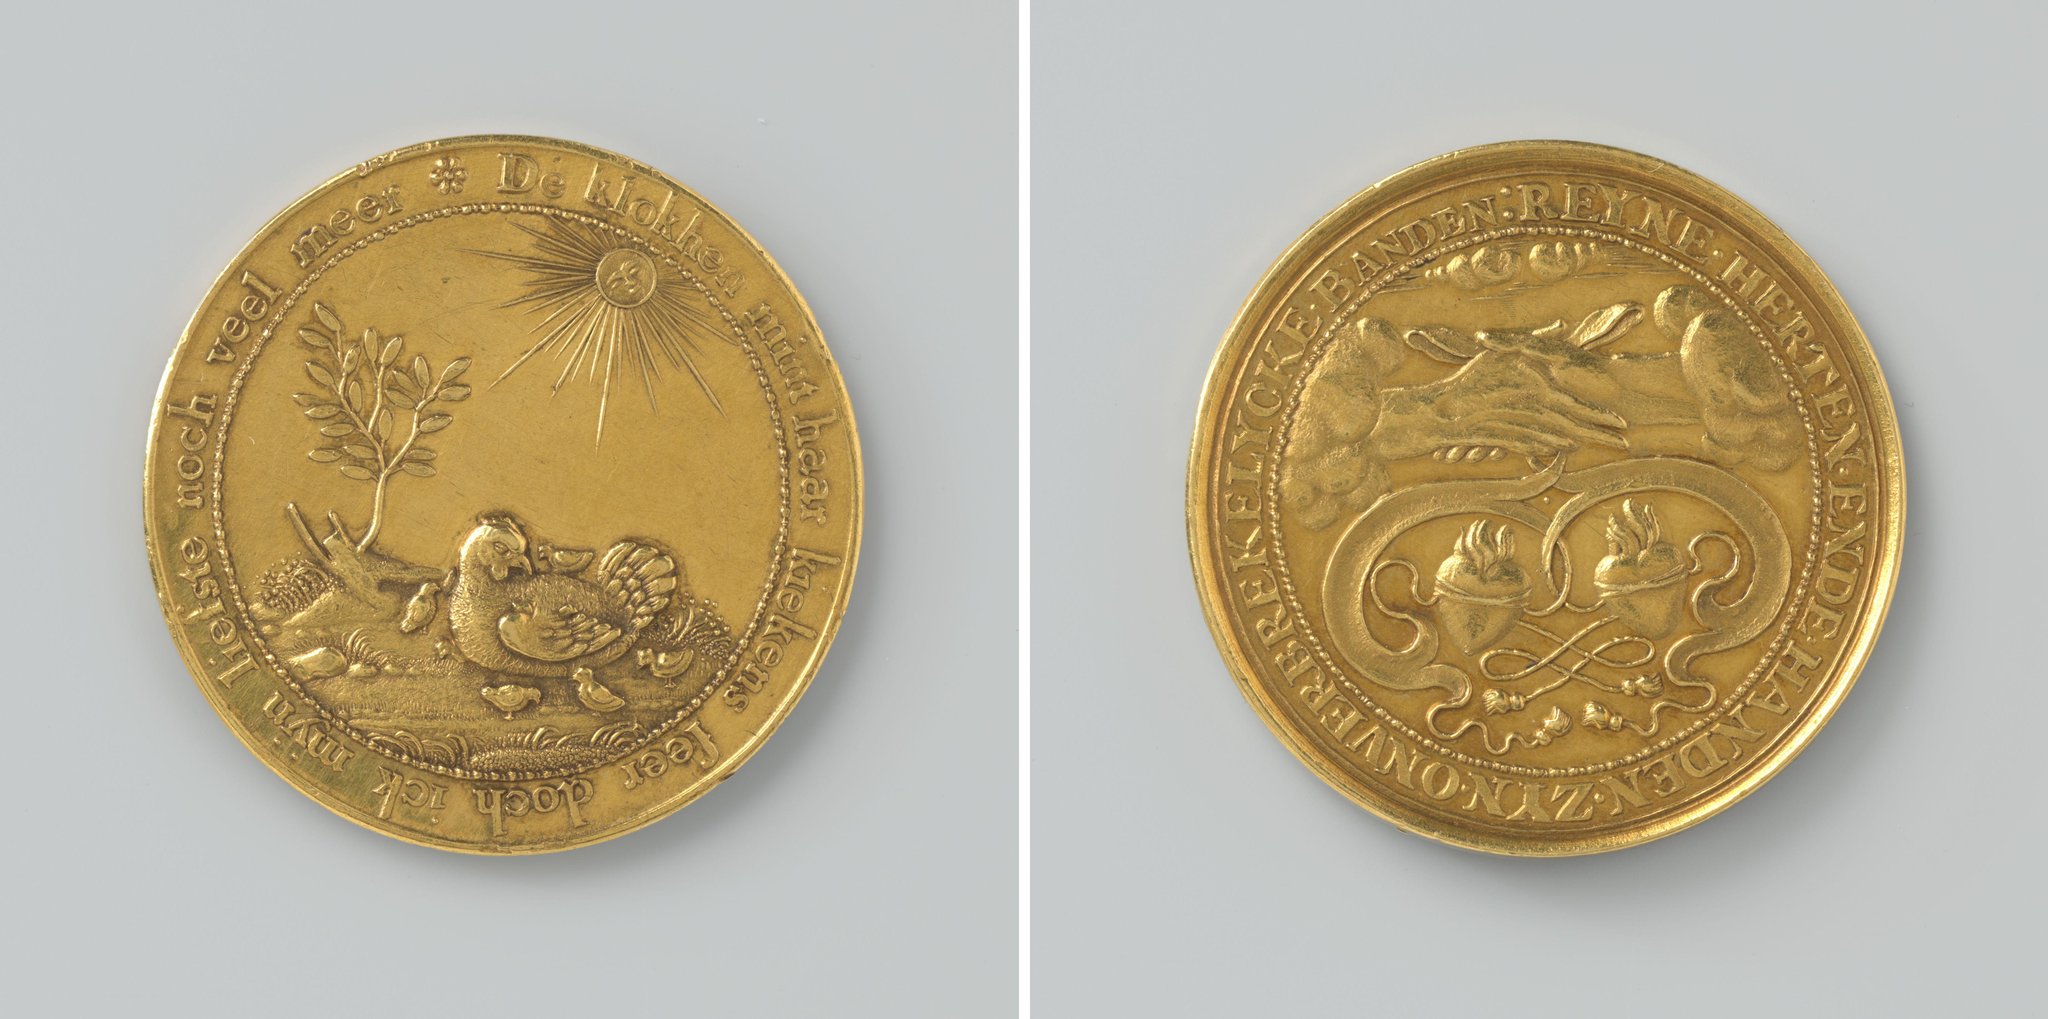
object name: family medal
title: Algemene huwelijkspenning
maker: Anonymous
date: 1640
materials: gold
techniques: striking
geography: netherlands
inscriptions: circumscription: ‘De klokhen mint haar kiekens seer, doch ick mijn liefste noch veel meer’, circumscription: ‘REYNE.HERTEN.ENDE.HANDEN.ZYN.ONVERBREKELYCKE.BANDEN’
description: Geslagen gouden penning . Voorzijde: kloek met 5 kuikens onder stralende zon met gezicht,en links een struik, binnen omschrift; keerzijde: twee uit wolken komende handen die in elkaar grijpen, waaronder twee door linten met elkaar verbonden brandende harten, binnen omschrift en hogere rand.